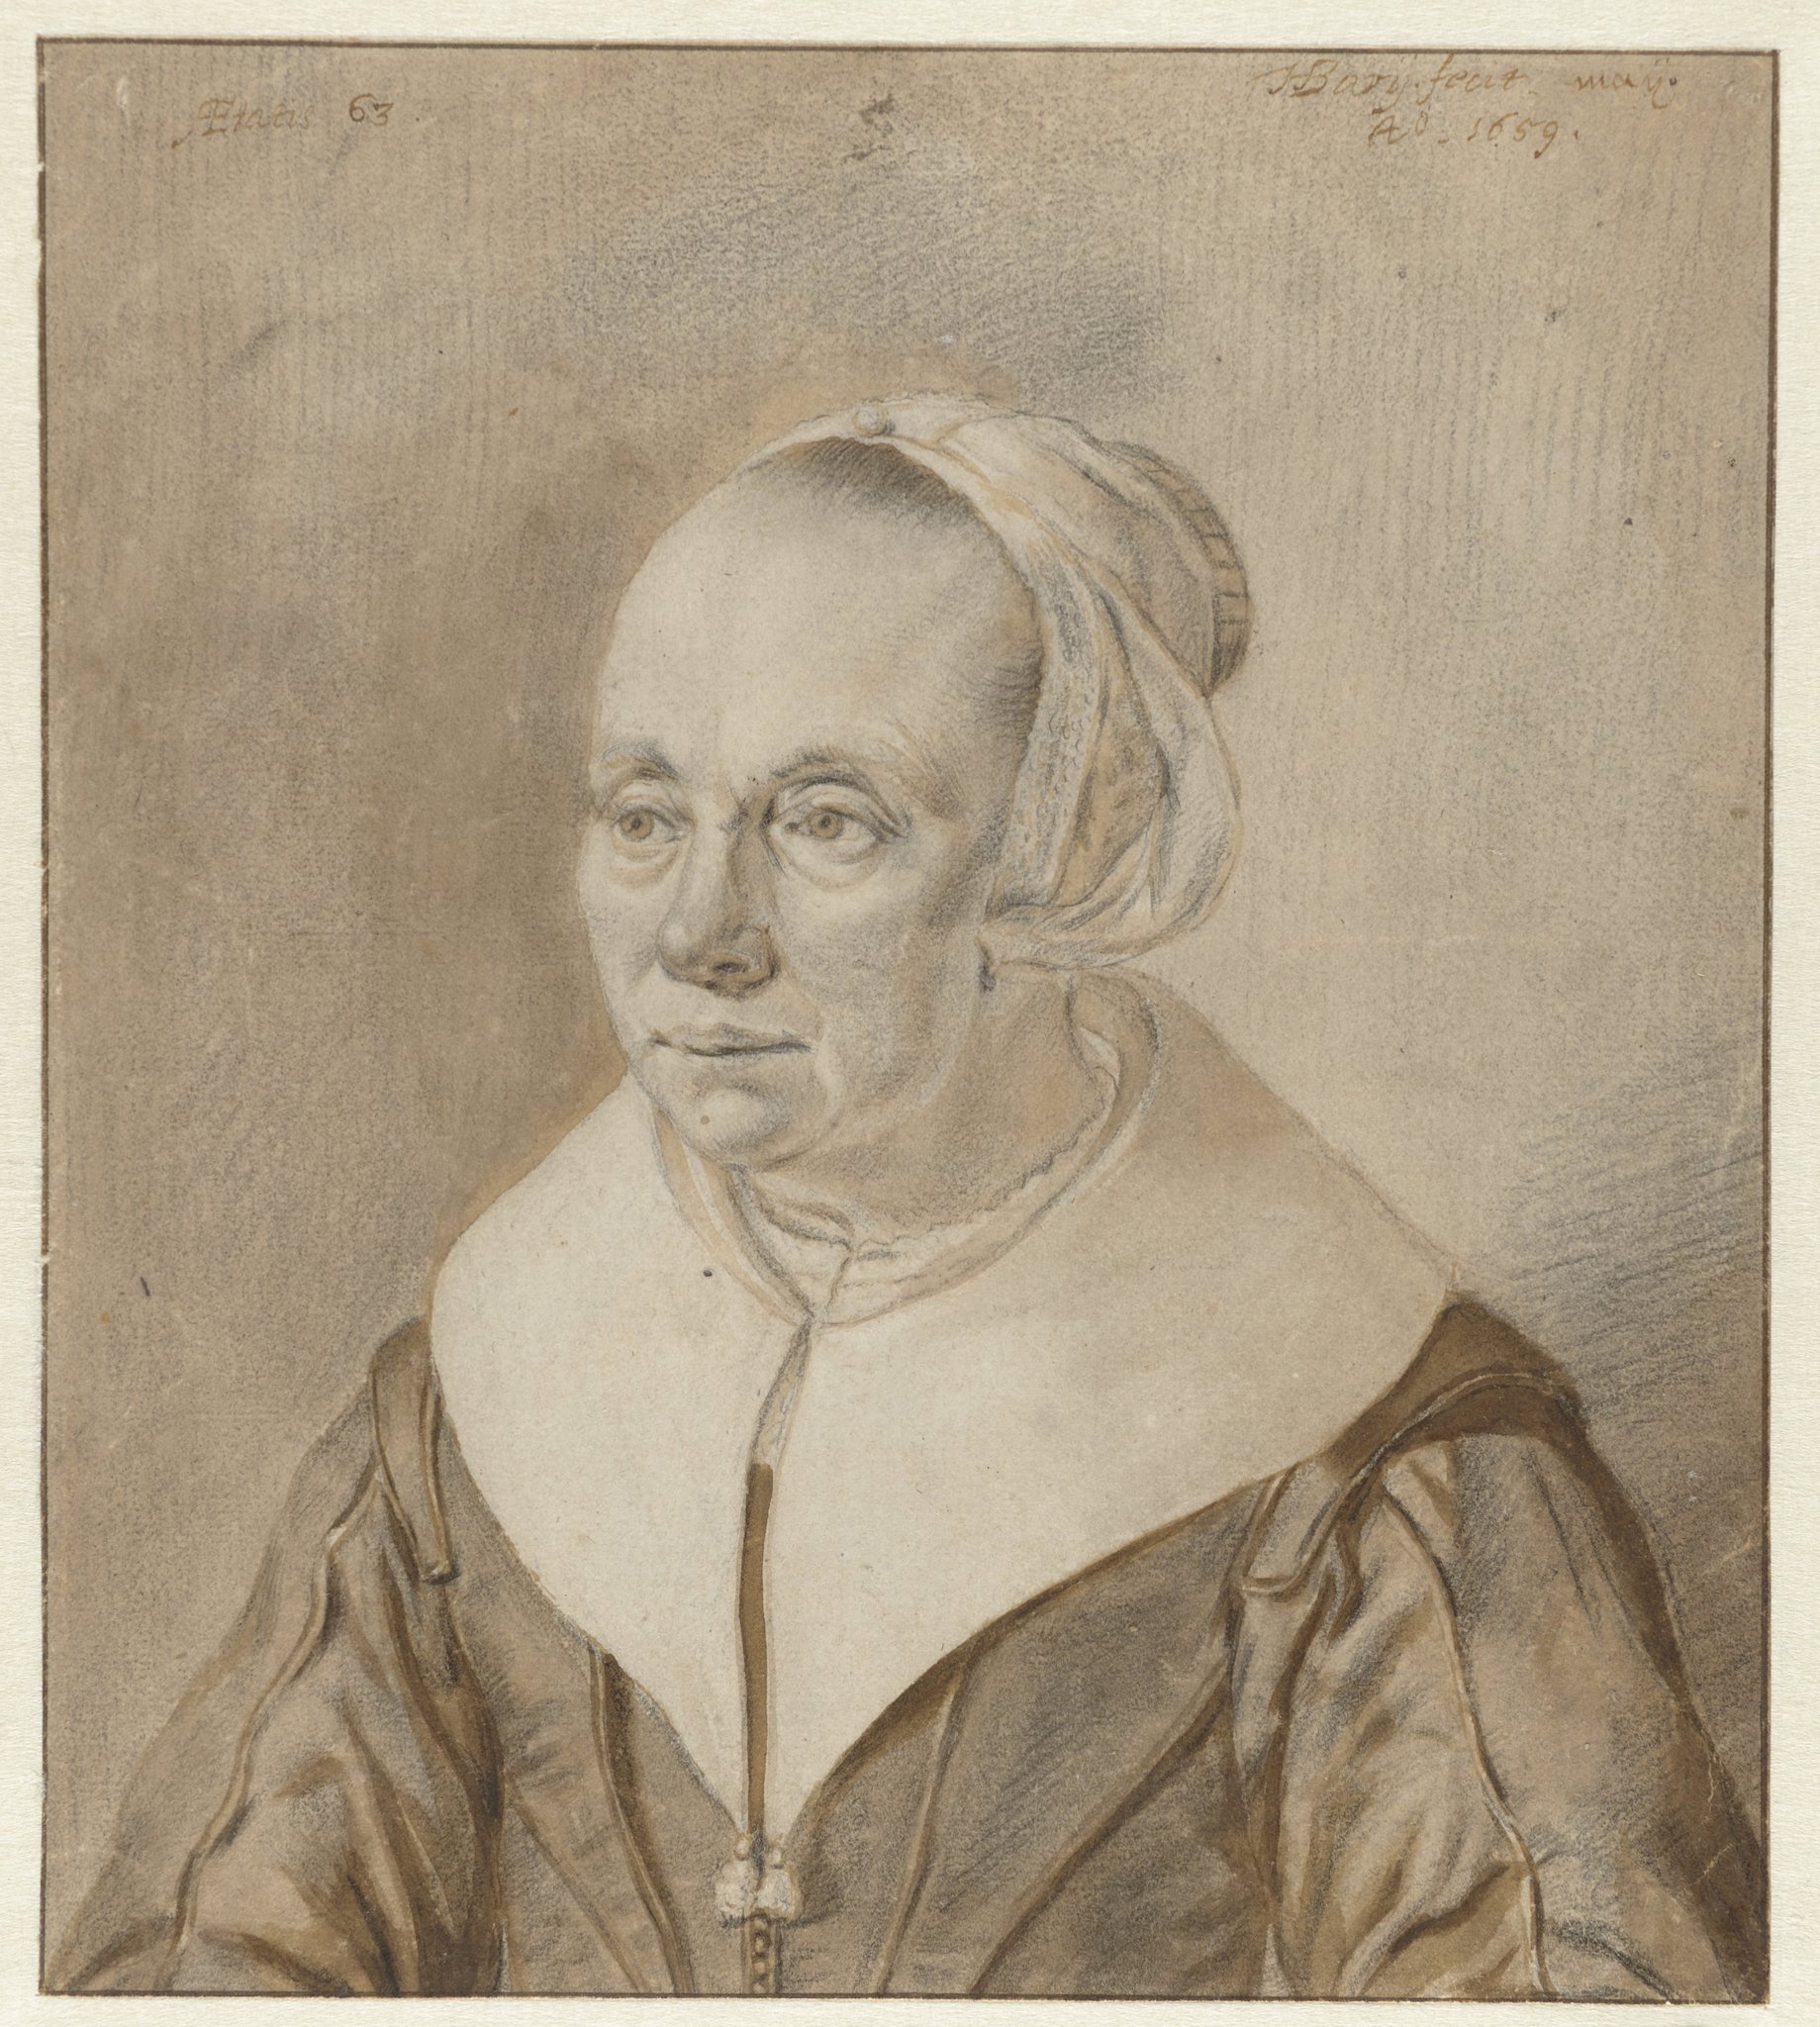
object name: drawing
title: Portret van een 63-jarige vrouw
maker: hendrik bary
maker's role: draughtsman, print maker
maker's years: 1640-1707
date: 1605-1659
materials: chalk, paper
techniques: brush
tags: historical persons not known by name - bb - woman, old woman